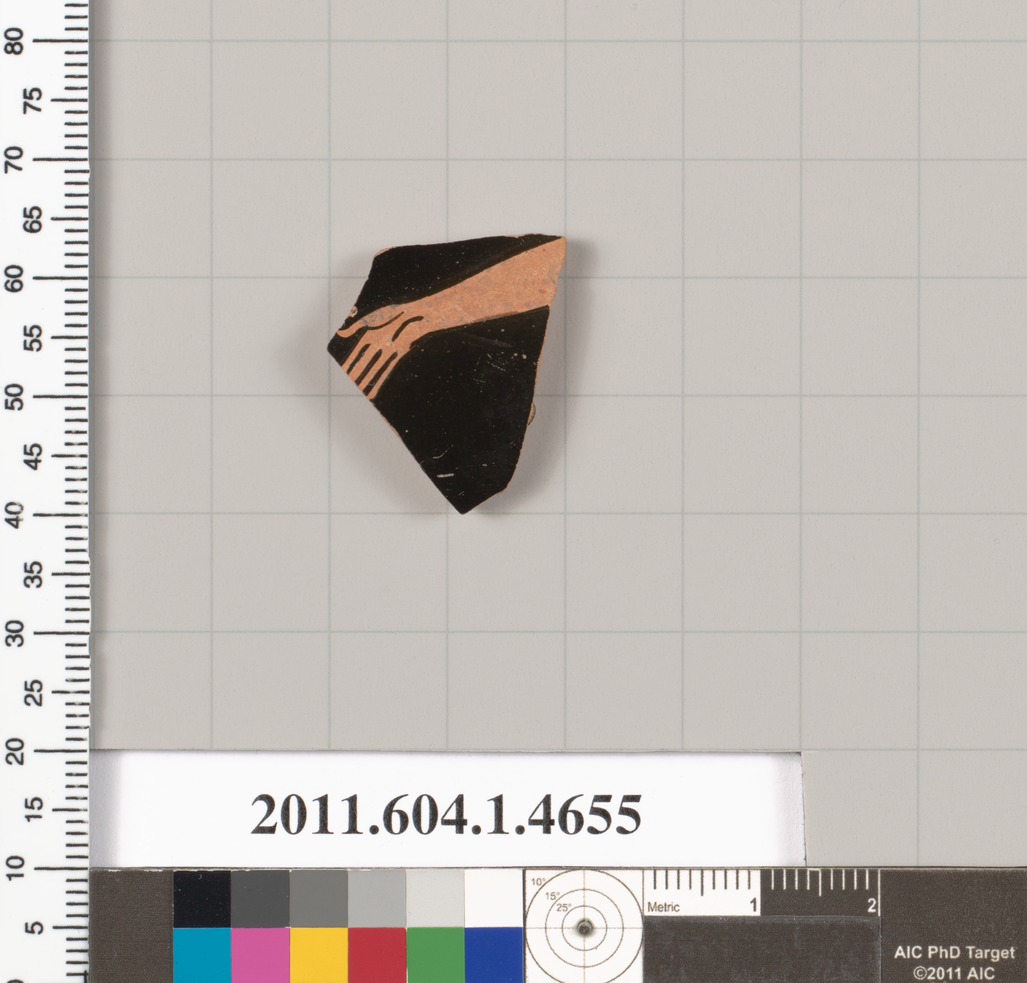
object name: kylix fragment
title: Terracotta fragment of a kylix (drinking cup)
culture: greek, attic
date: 520-500 BCE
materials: terracotta